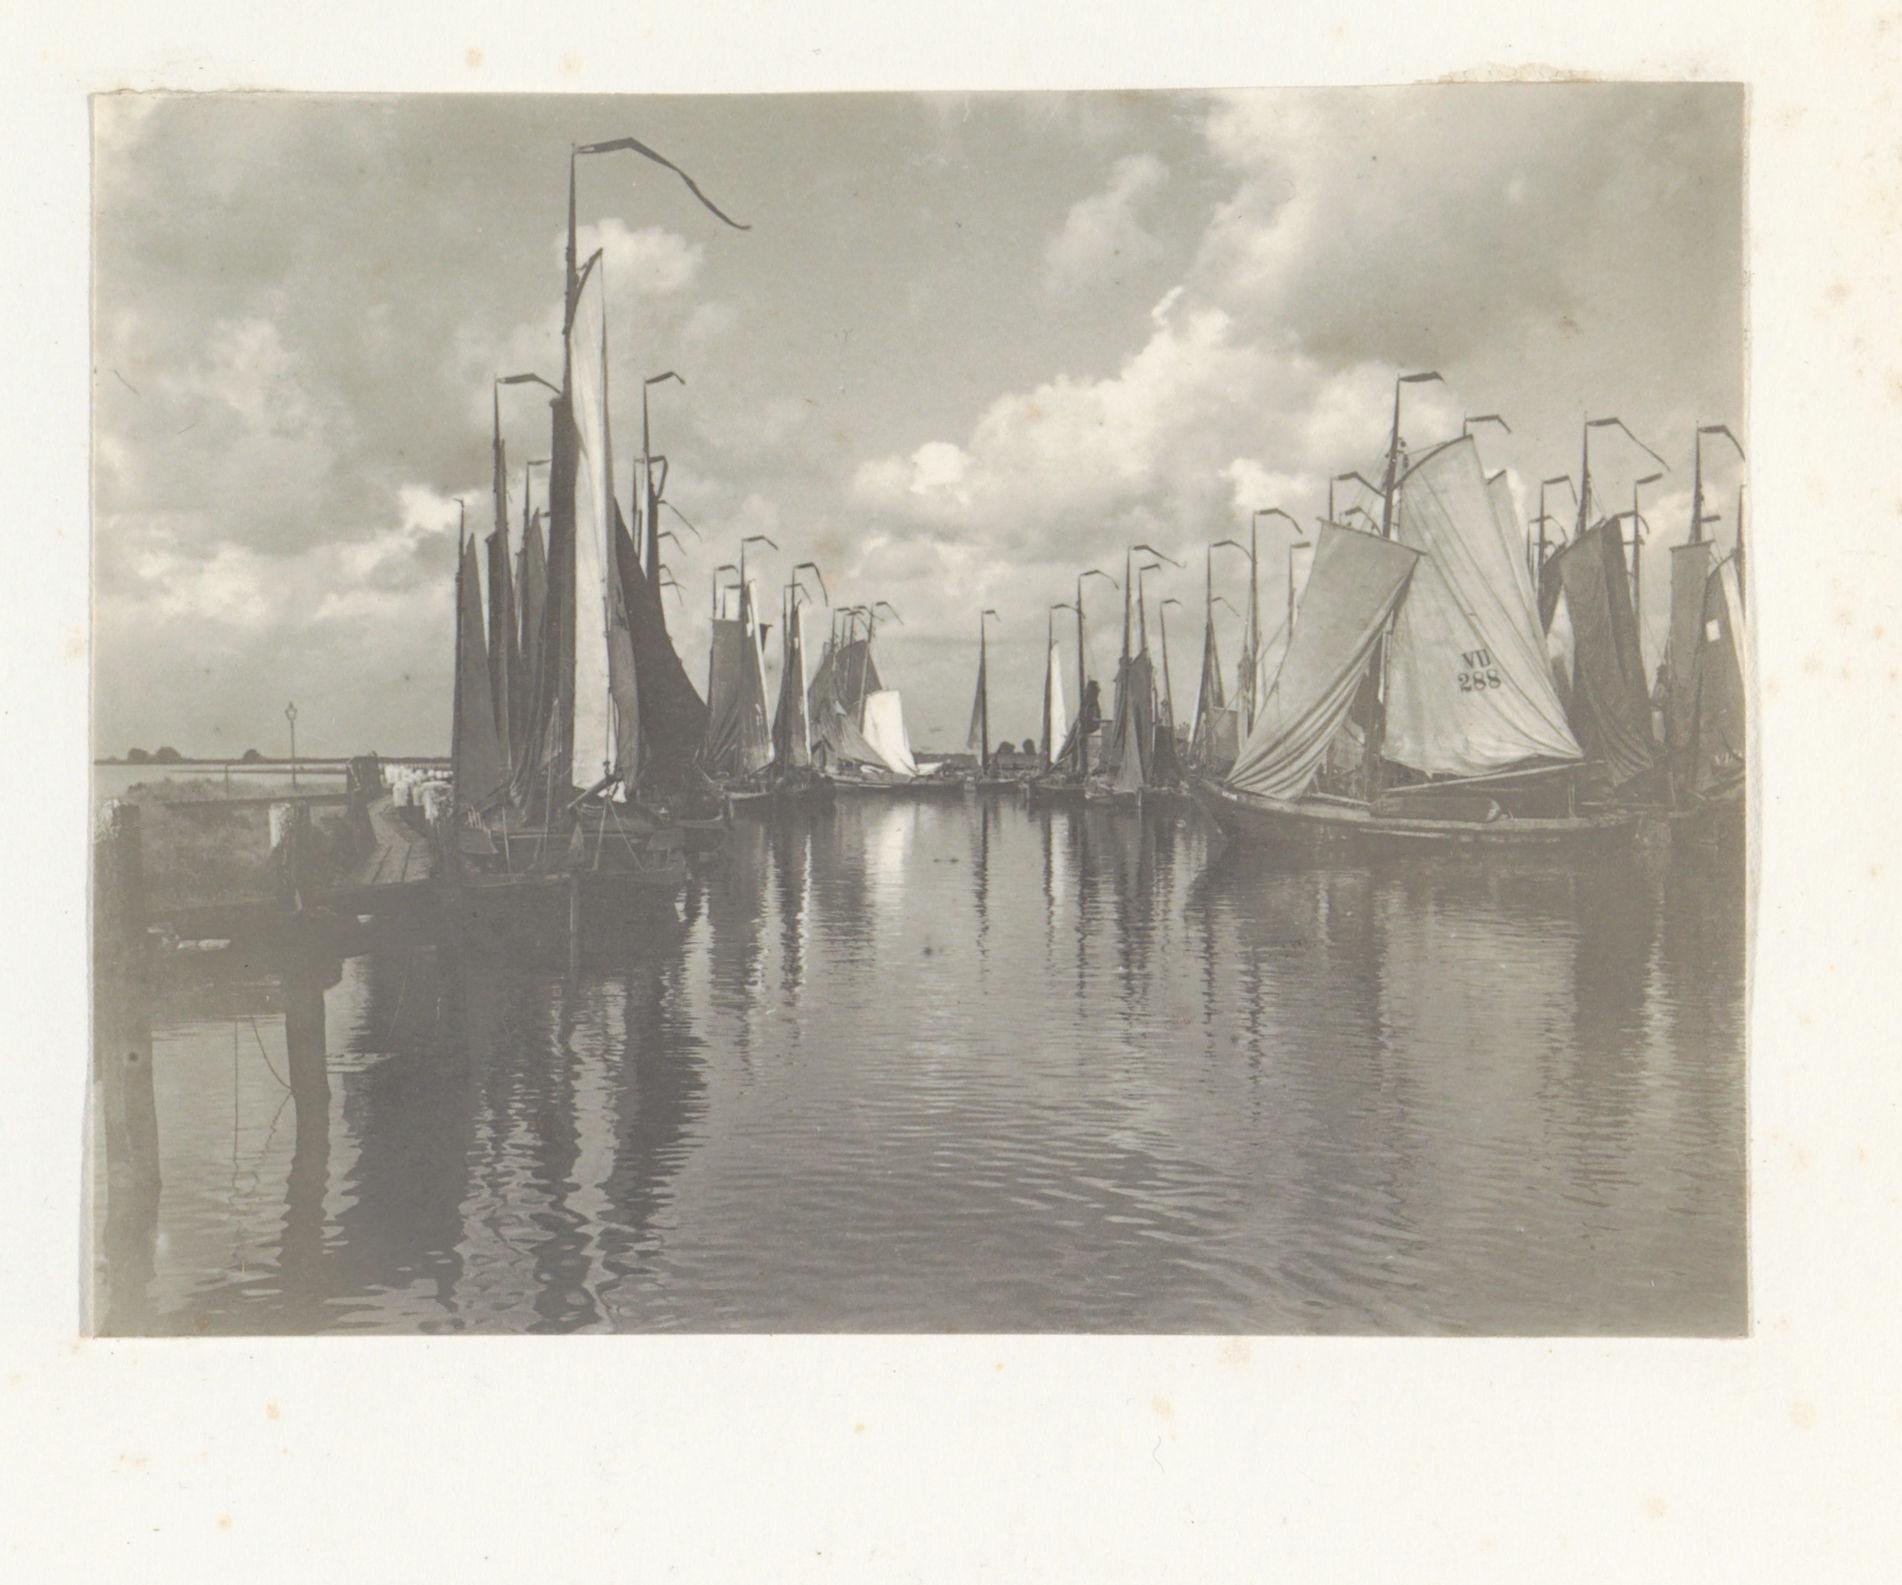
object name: photograph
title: Portret van man in Volendamse klederdracht, zittend aan een tafel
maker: george hidderley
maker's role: fotograaf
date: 1900-1910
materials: paper, photographic support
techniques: gelatin silver print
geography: volendam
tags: sitting figure, pipe ~ tobacco, folk costume, regional costume, drinking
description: Onderdeel van fotoalbum met opnames van Volendam, Dordrecht, Gorinchem en Woudrichem.